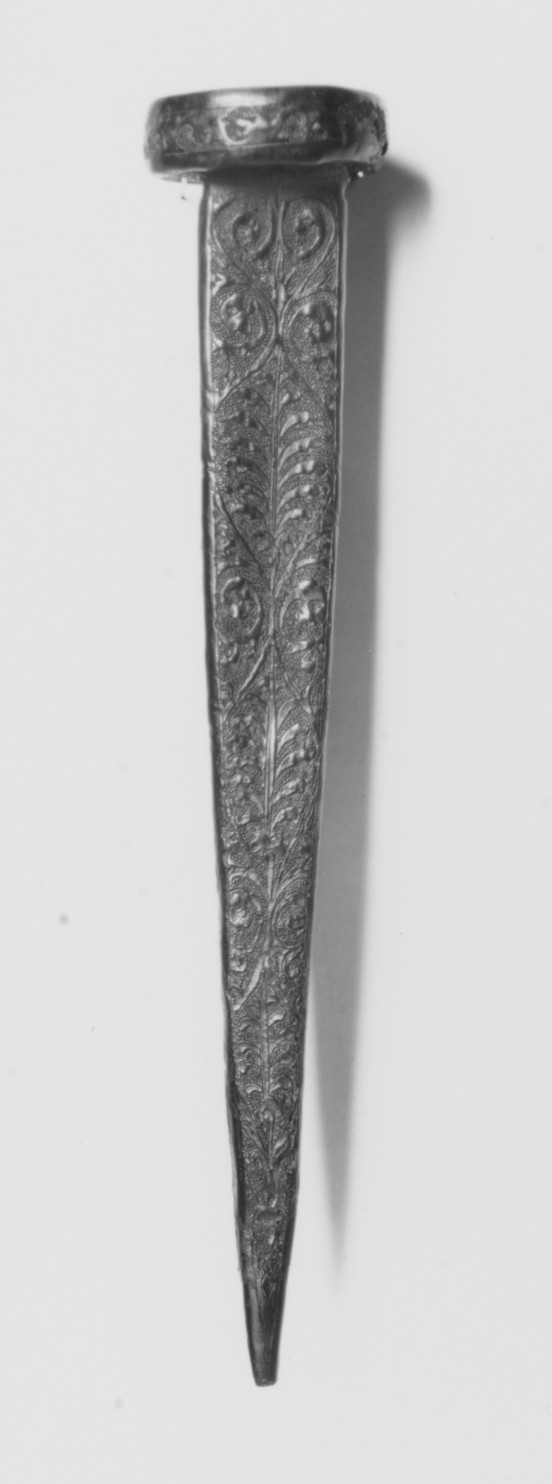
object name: sheath for a roundel dagger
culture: italian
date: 1500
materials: leather, wood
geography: italy